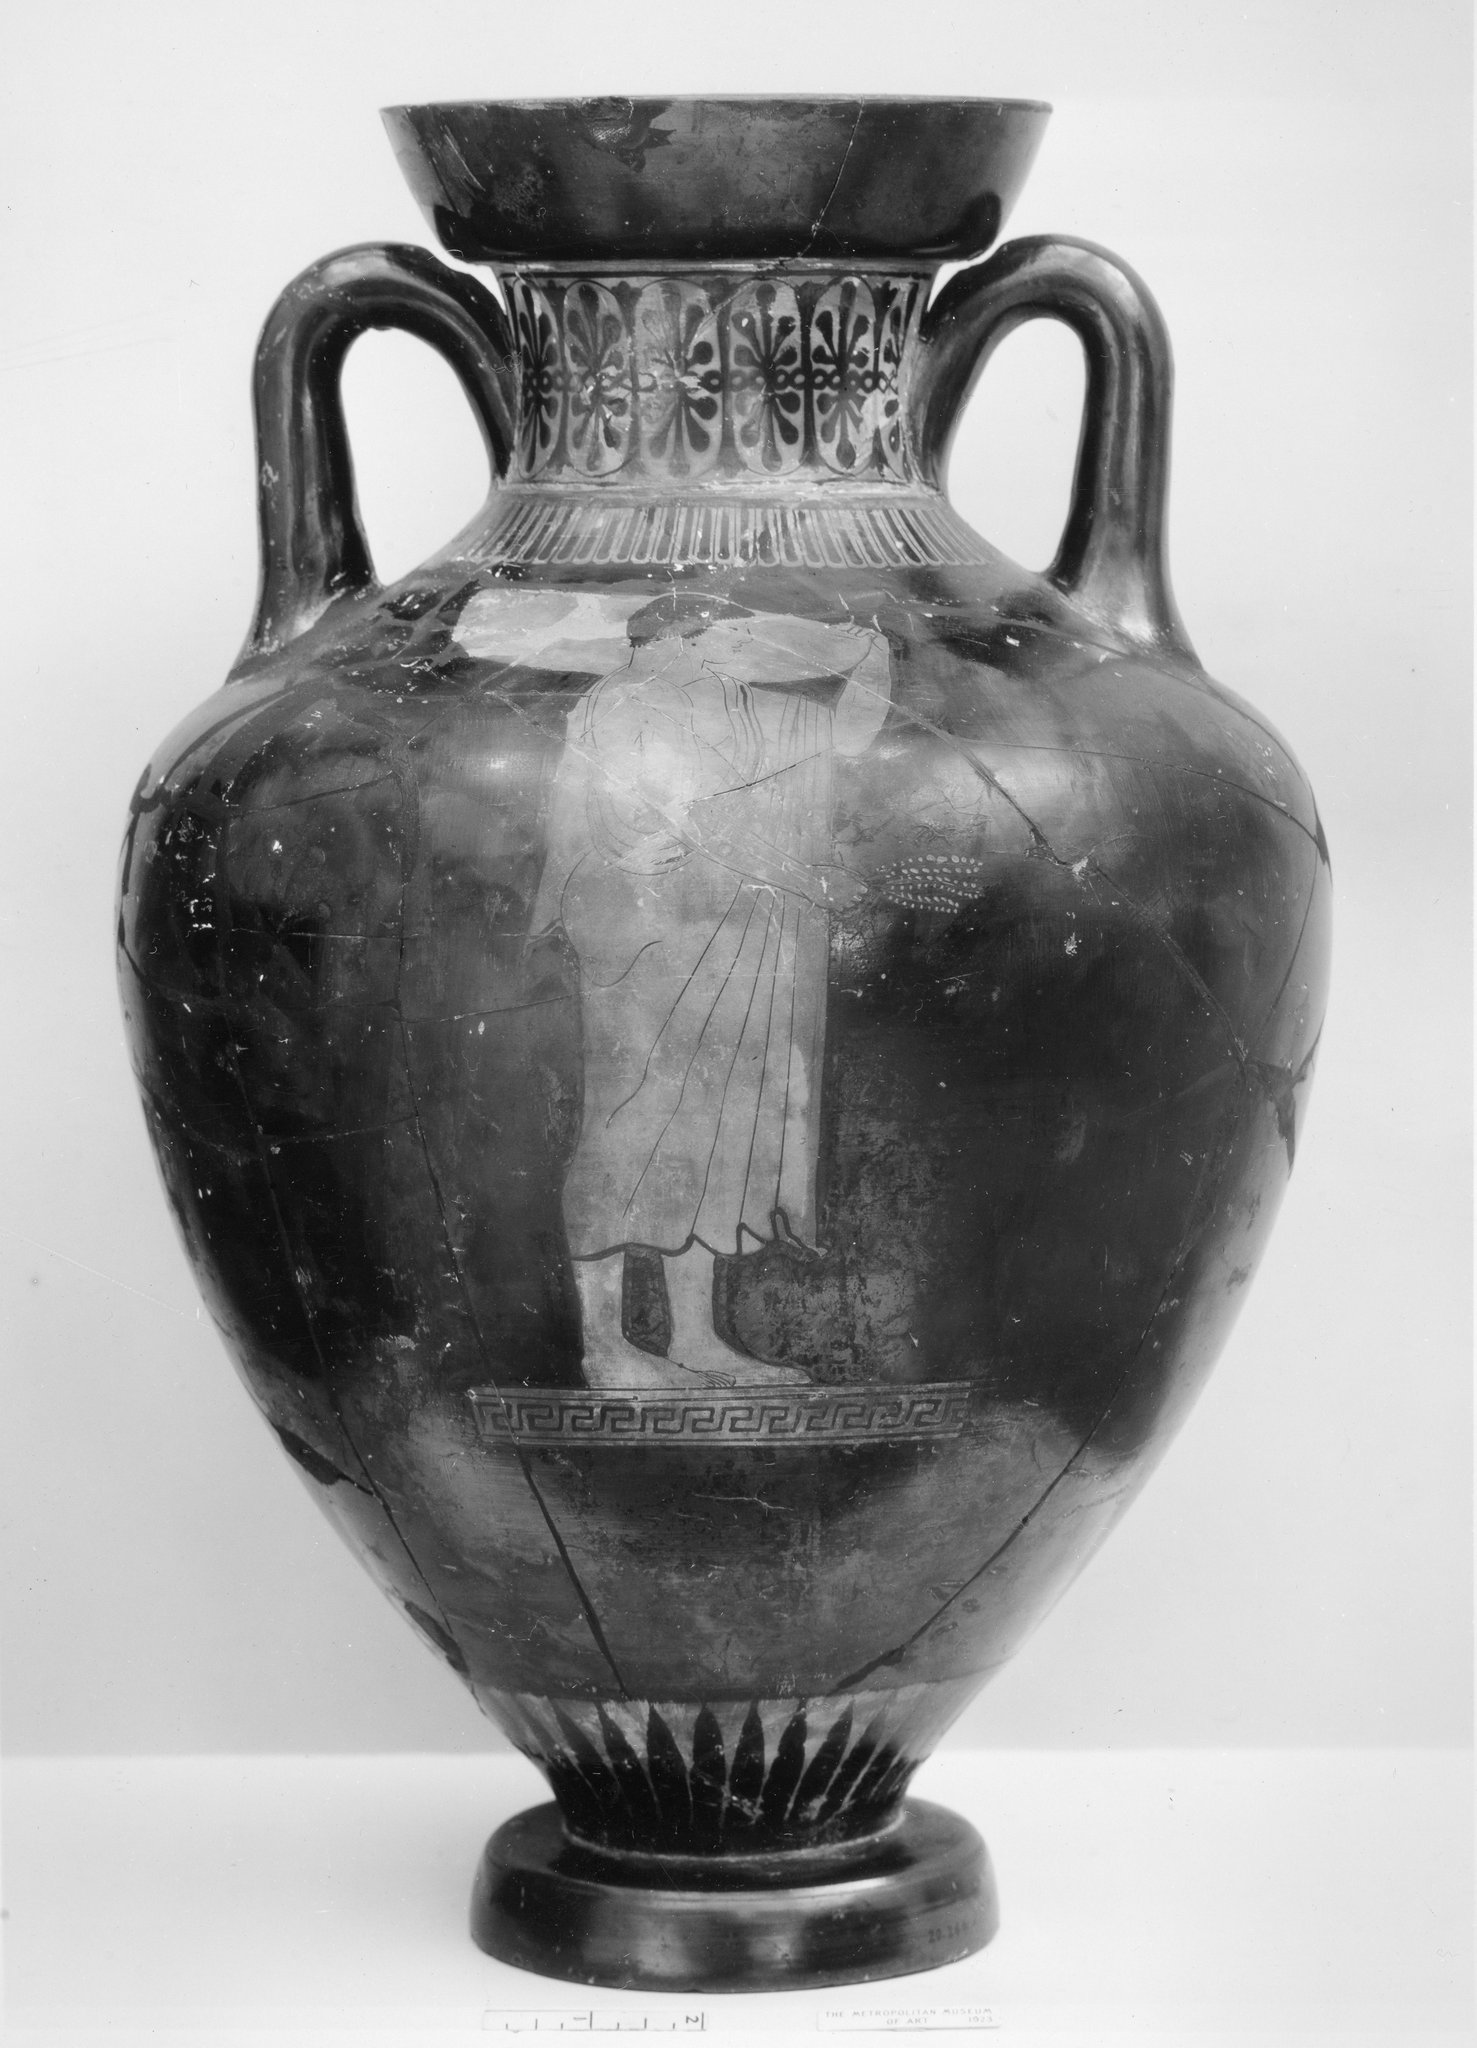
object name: neck amphora of panathenaic shape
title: Terracotta neck-amphora of Panathenaic shape (jar)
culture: greek, attic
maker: syleus painter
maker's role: artist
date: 480-470 BCE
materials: terracotta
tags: men